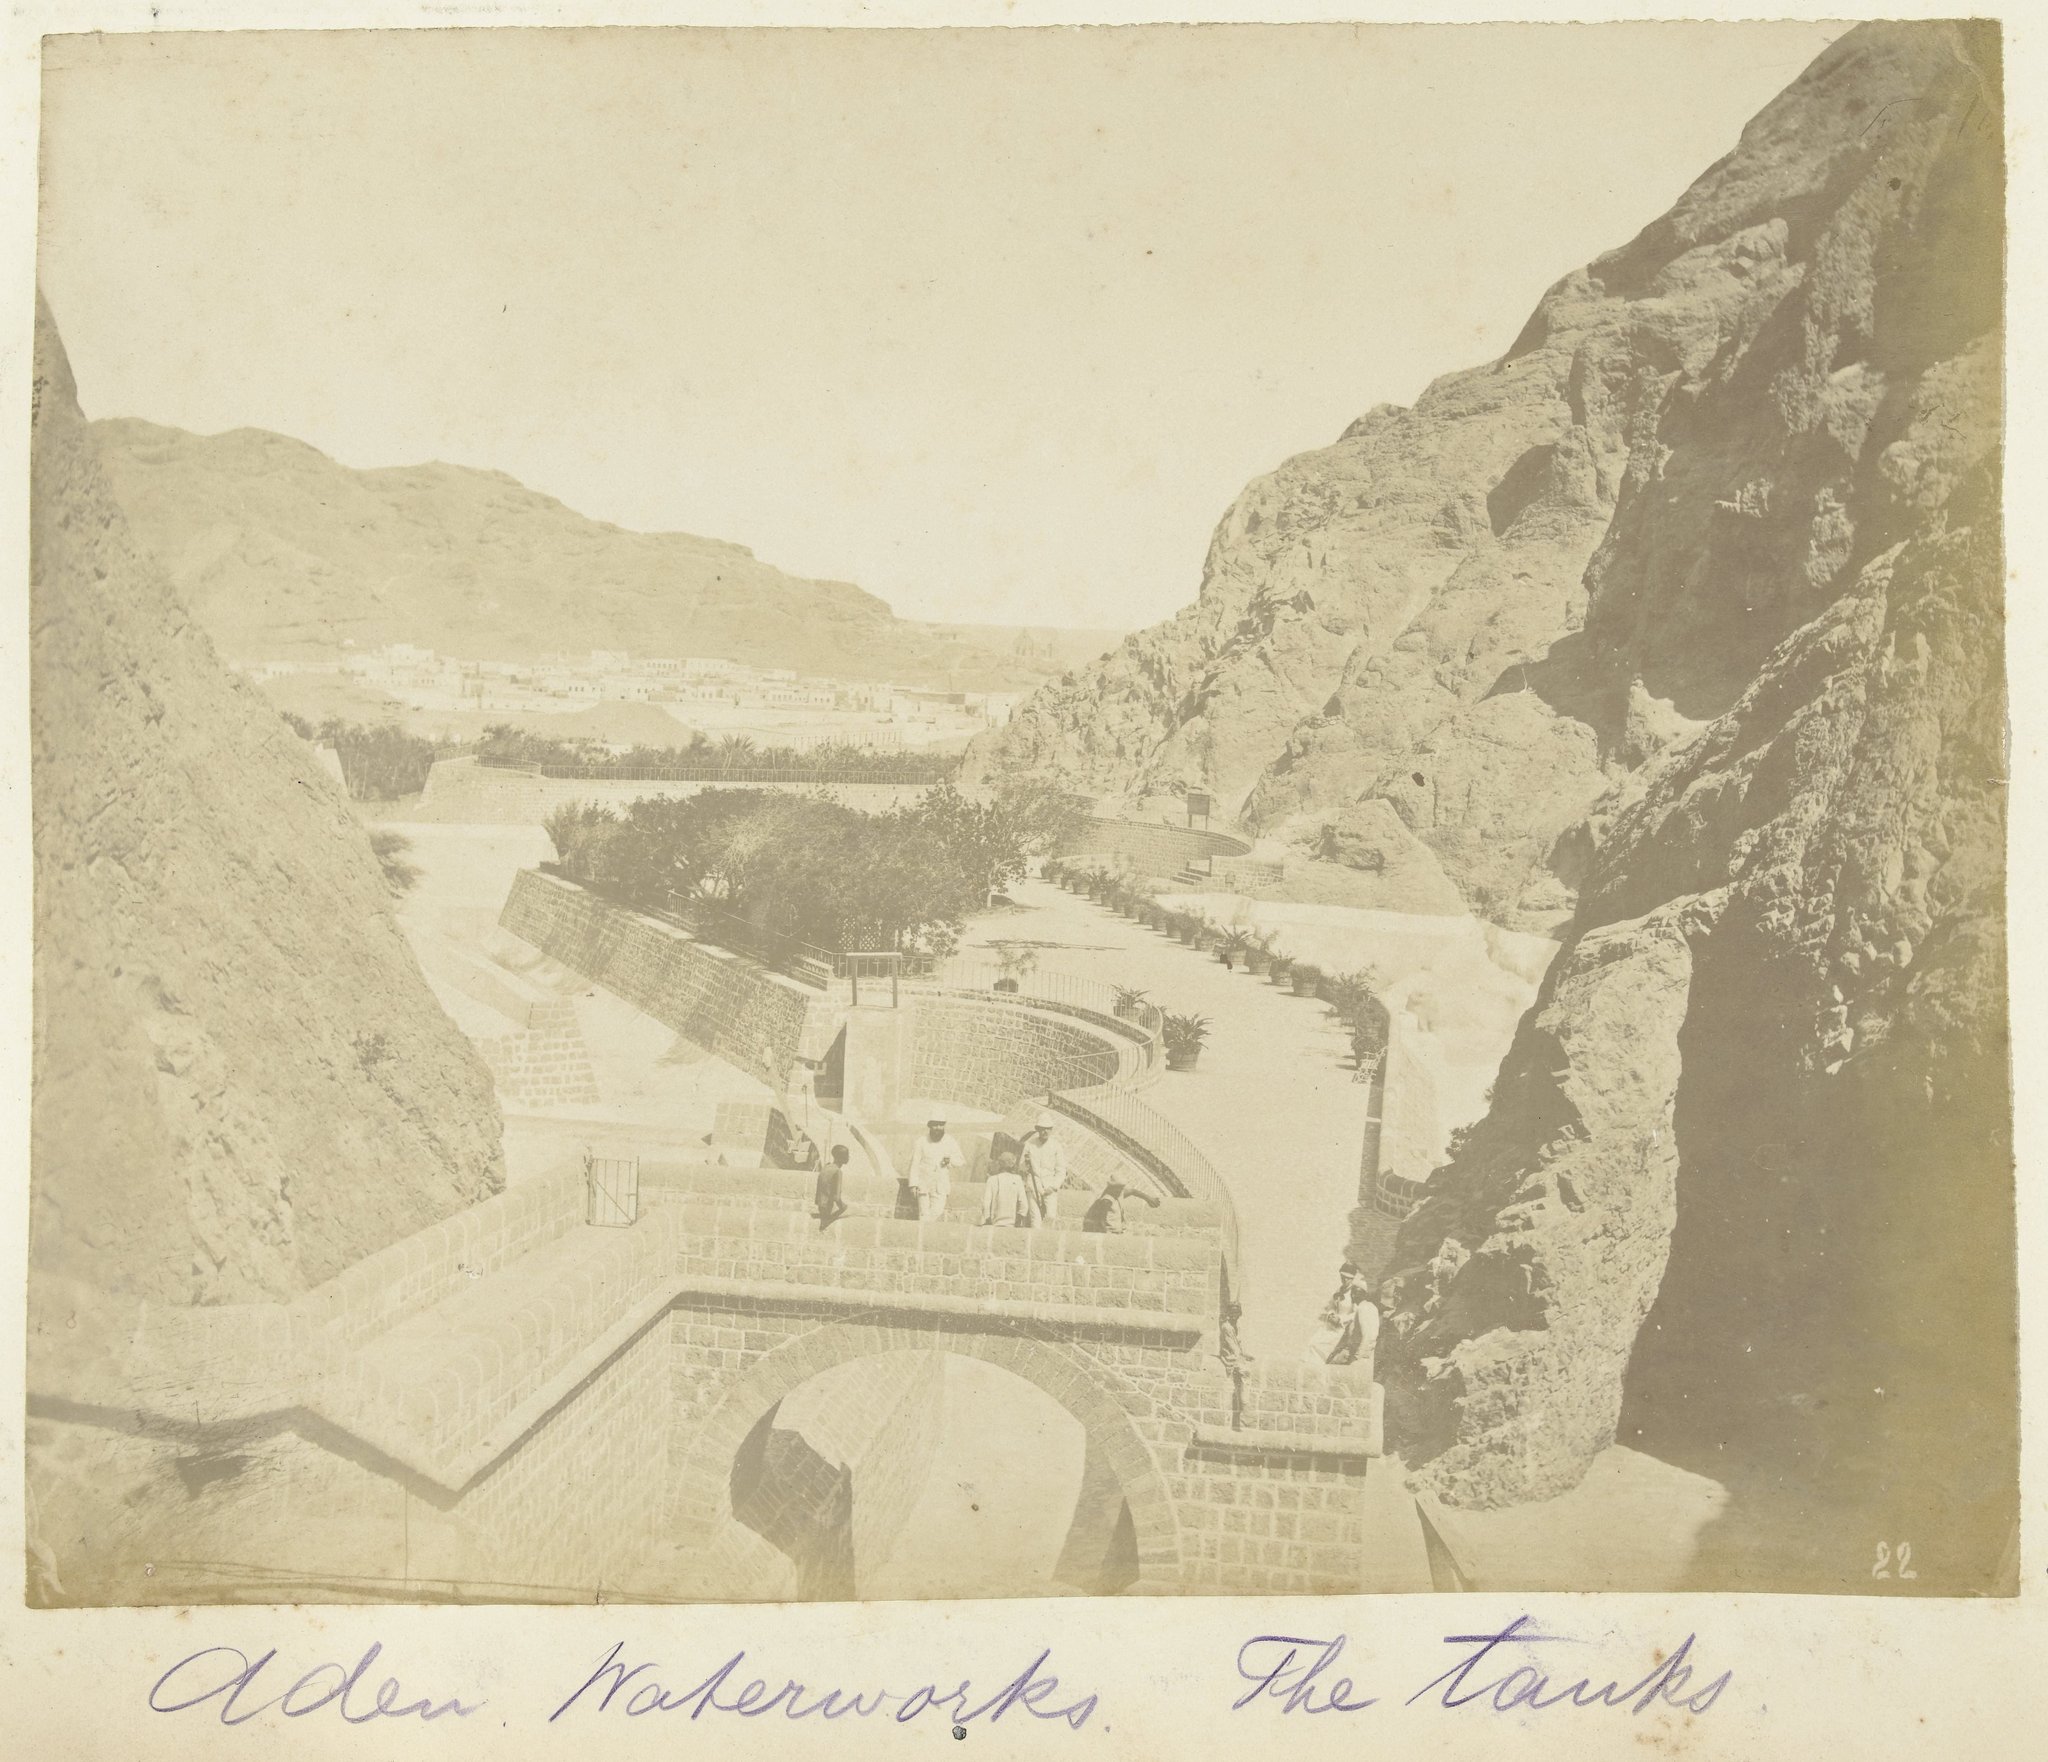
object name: photograph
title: Zicht over de waterbassins en aangelegde kanalen in het bergachtige landschap in Aden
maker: Anonymous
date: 1890-1910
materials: cardboard, paper, photographic support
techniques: gelatin silver print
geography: aden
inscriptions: caption: ‘Aden waterworks. The tanks’